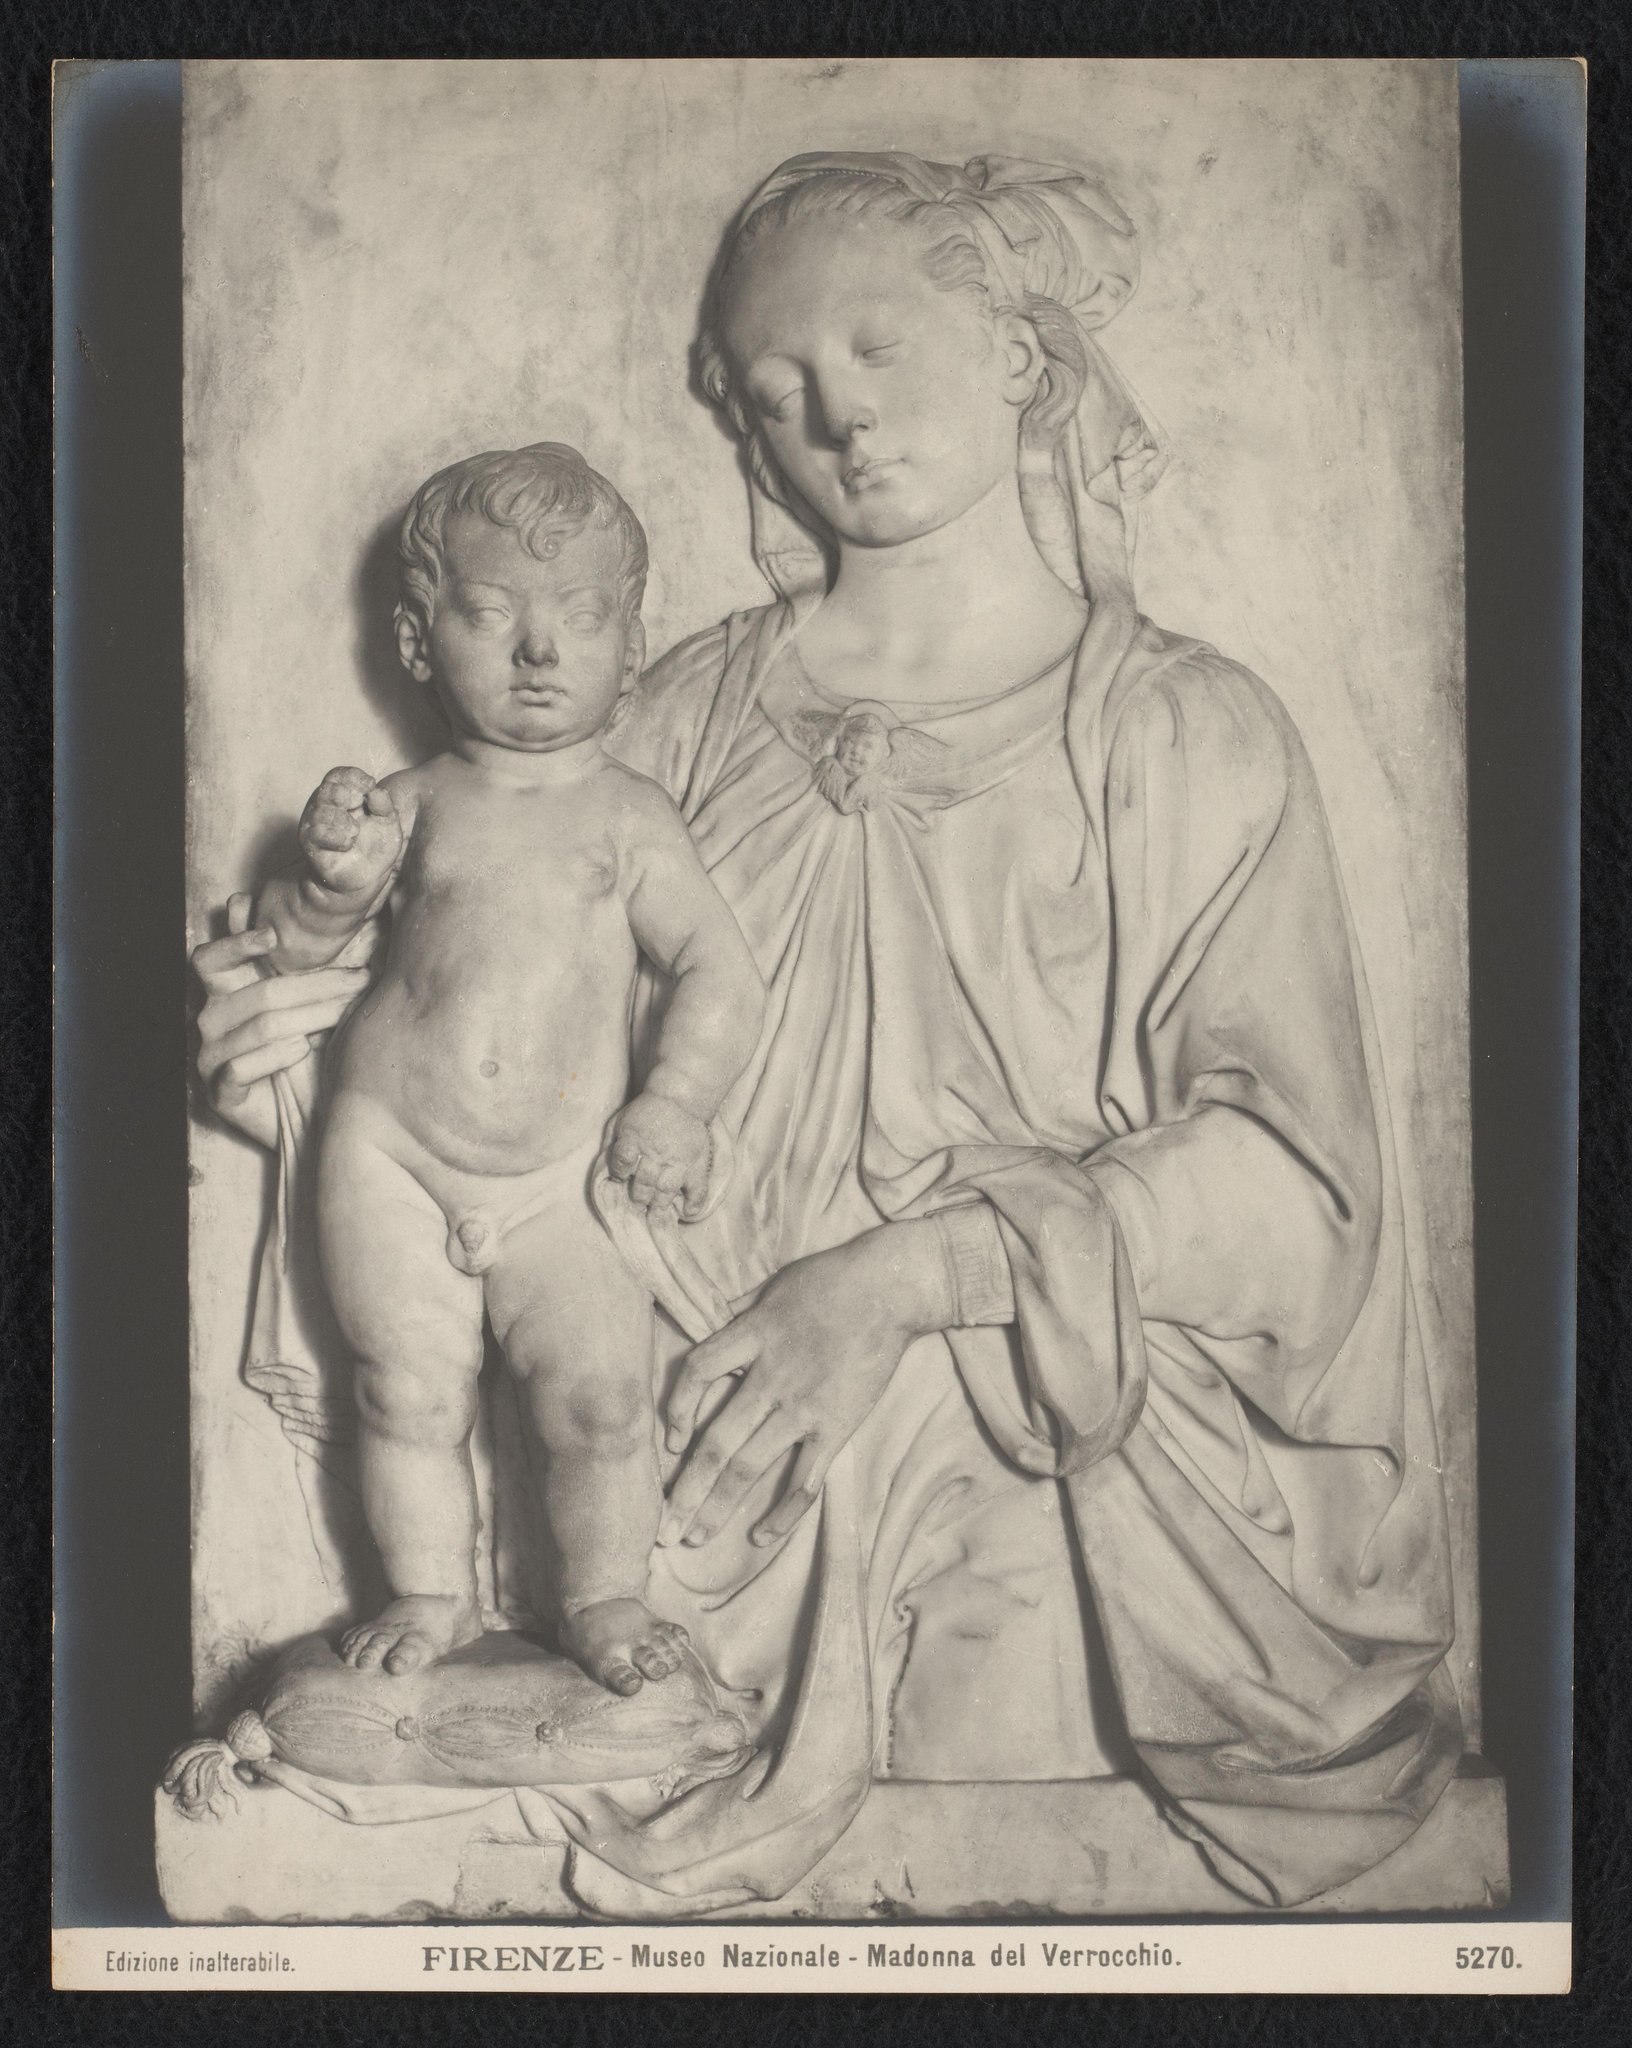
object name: photograph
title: Firenze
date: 1901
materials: paper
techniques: gelatin silver print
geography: berlin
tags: madonna: i.e. mary with the christ-child, picture, painting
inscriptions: inscription: ‘Edizione inalterabile.’, number: ‘5270.’, collector's mark: ‘RIJKS SCHOOL VOOR KUNSTNIJVERHEID/ GROEP’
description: Deze foto maakt deel uit van een omslag.